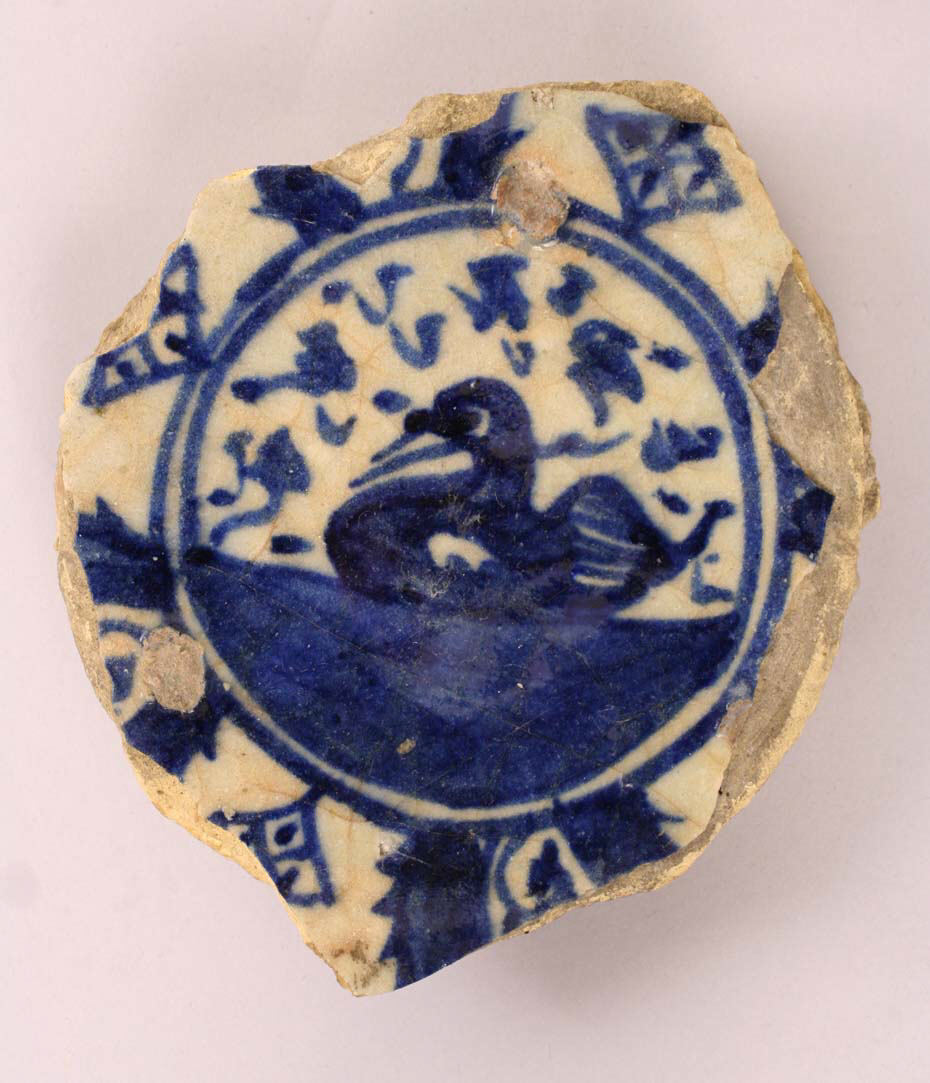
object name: fragment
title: Ceramic Fragment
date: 1201-1600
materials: glaze, stonepaste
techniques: painting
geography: egypt